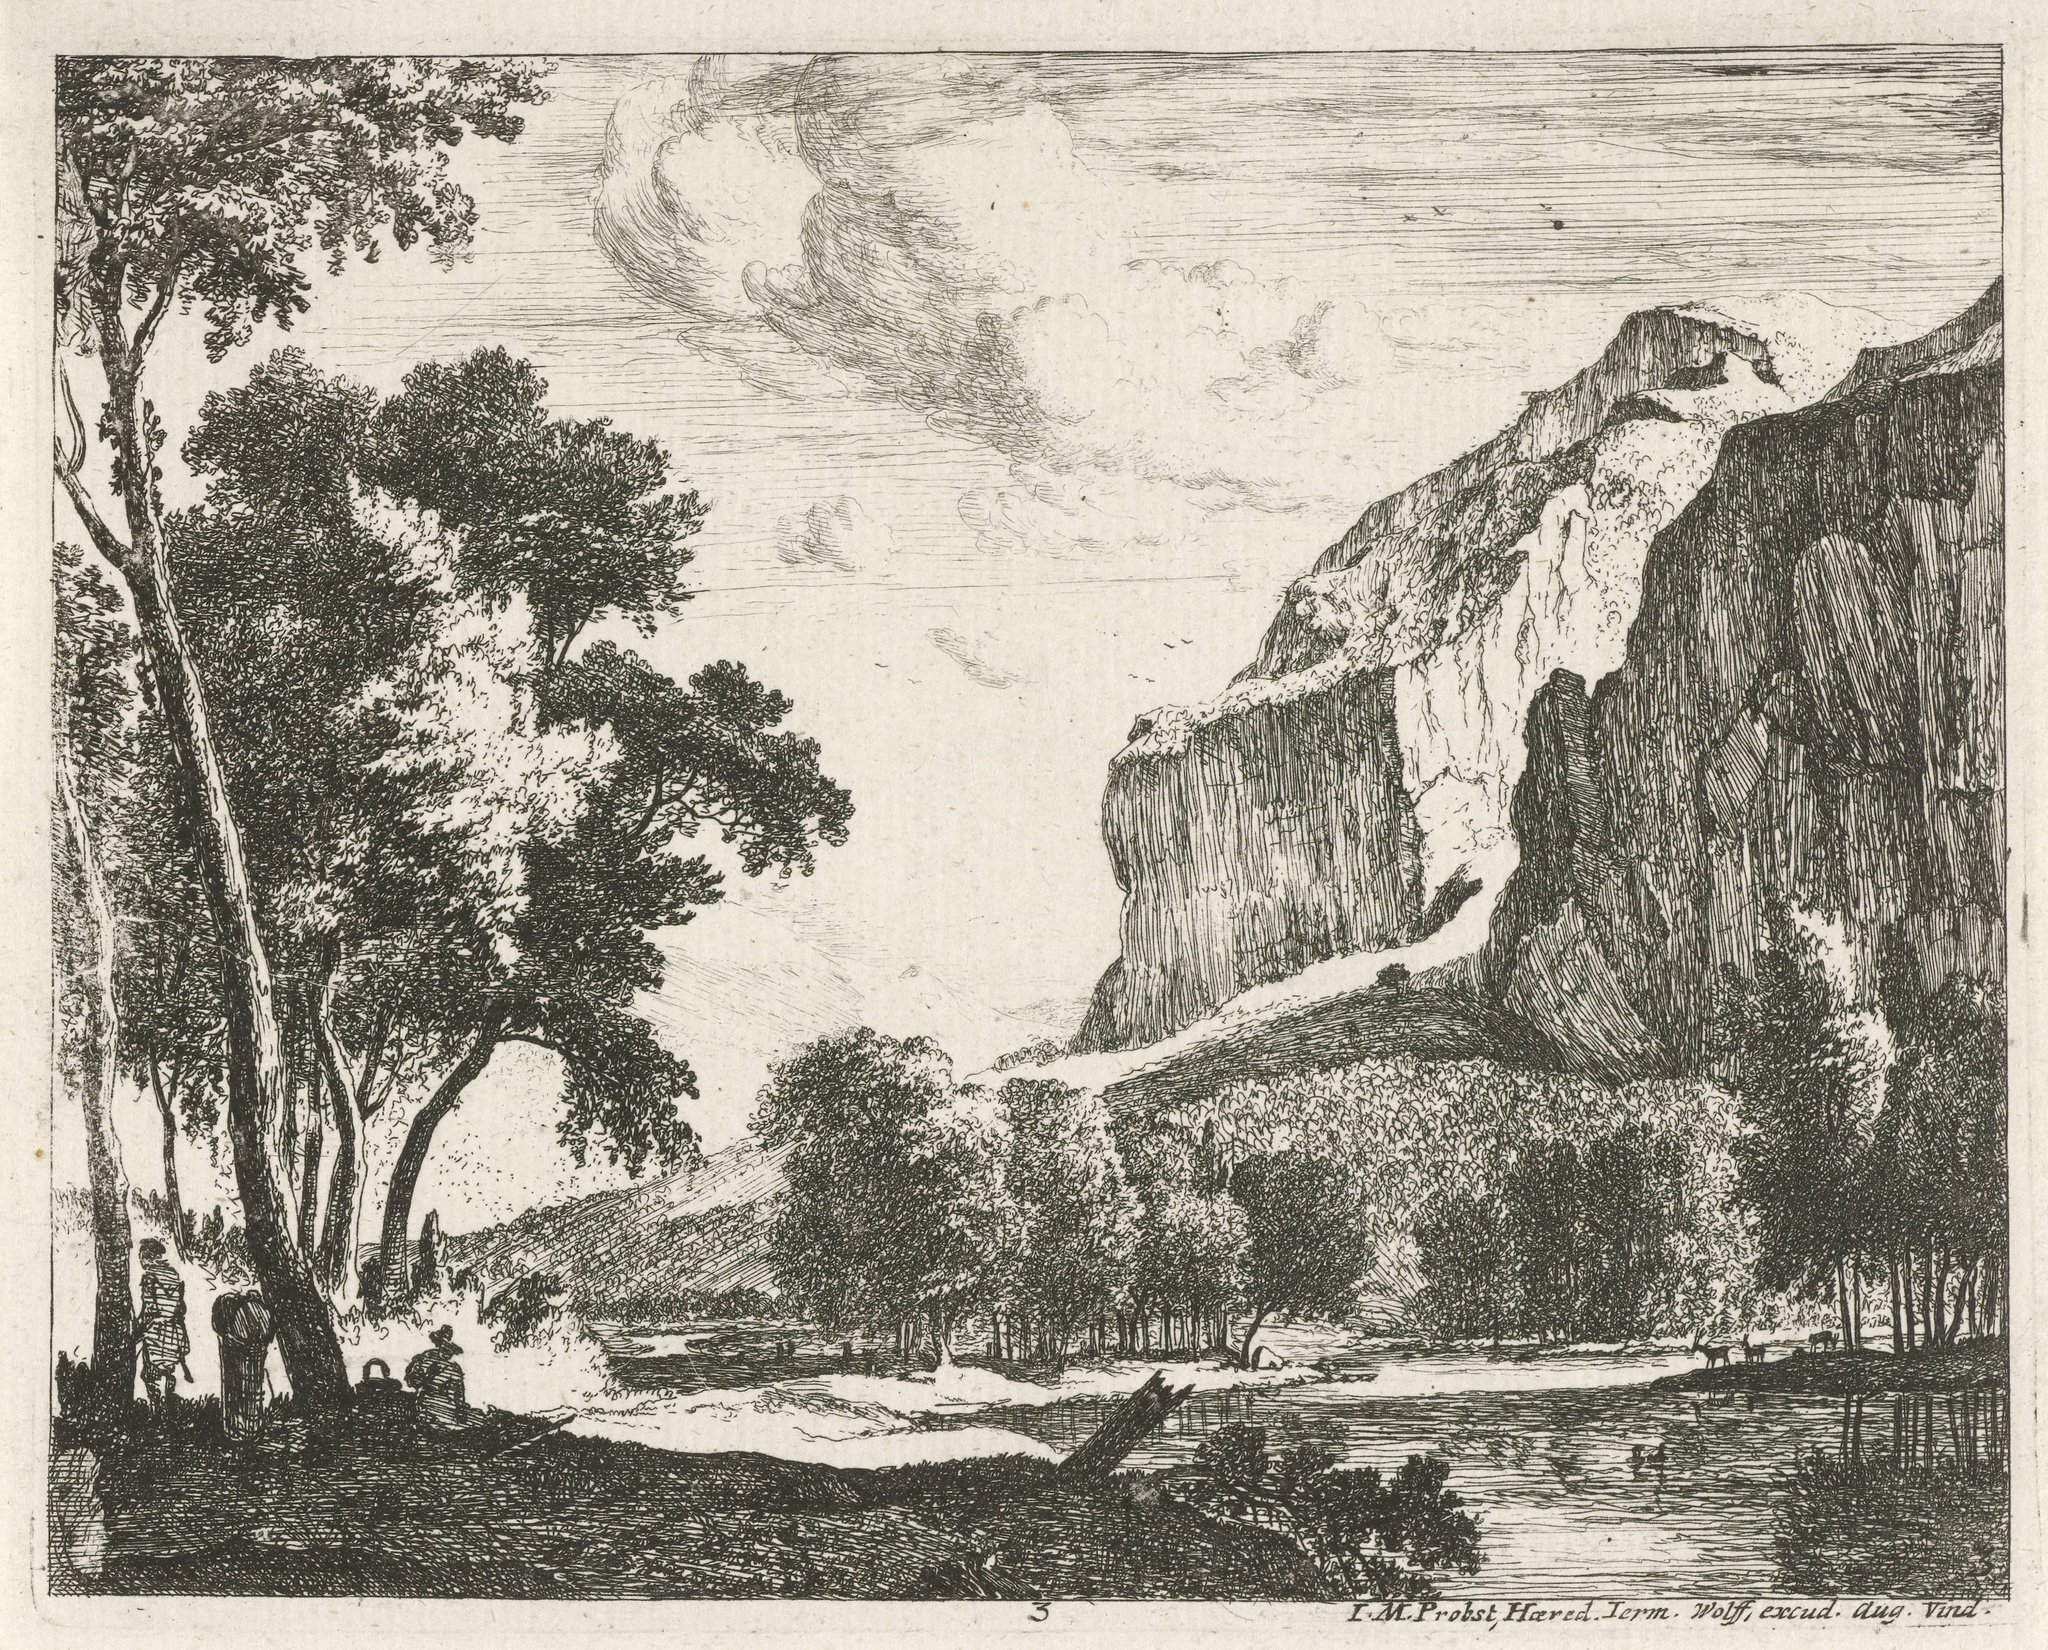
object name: print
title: Rivierlandschap met rotsen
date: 1737-1809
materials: paper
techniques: etching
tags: river, rock-formations, 'en route', traveller under way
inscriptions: collector's mark: Lugt 2228a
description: Gezicht op een Tiroler landschap met rotsformaties en een rivier. Op de voorgrond enkele figuren. Prent uit een serie van acht prenten met Tiroolse landschappen.